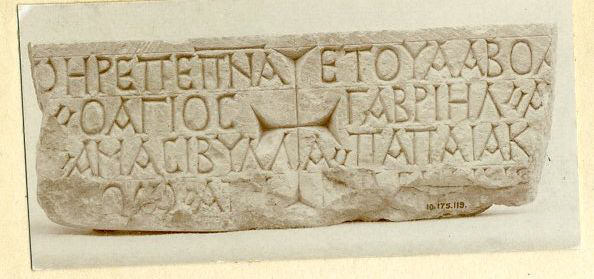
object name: block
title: Inscribed Block with a Cross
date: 501-700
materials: limestone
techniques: incising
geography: egypt